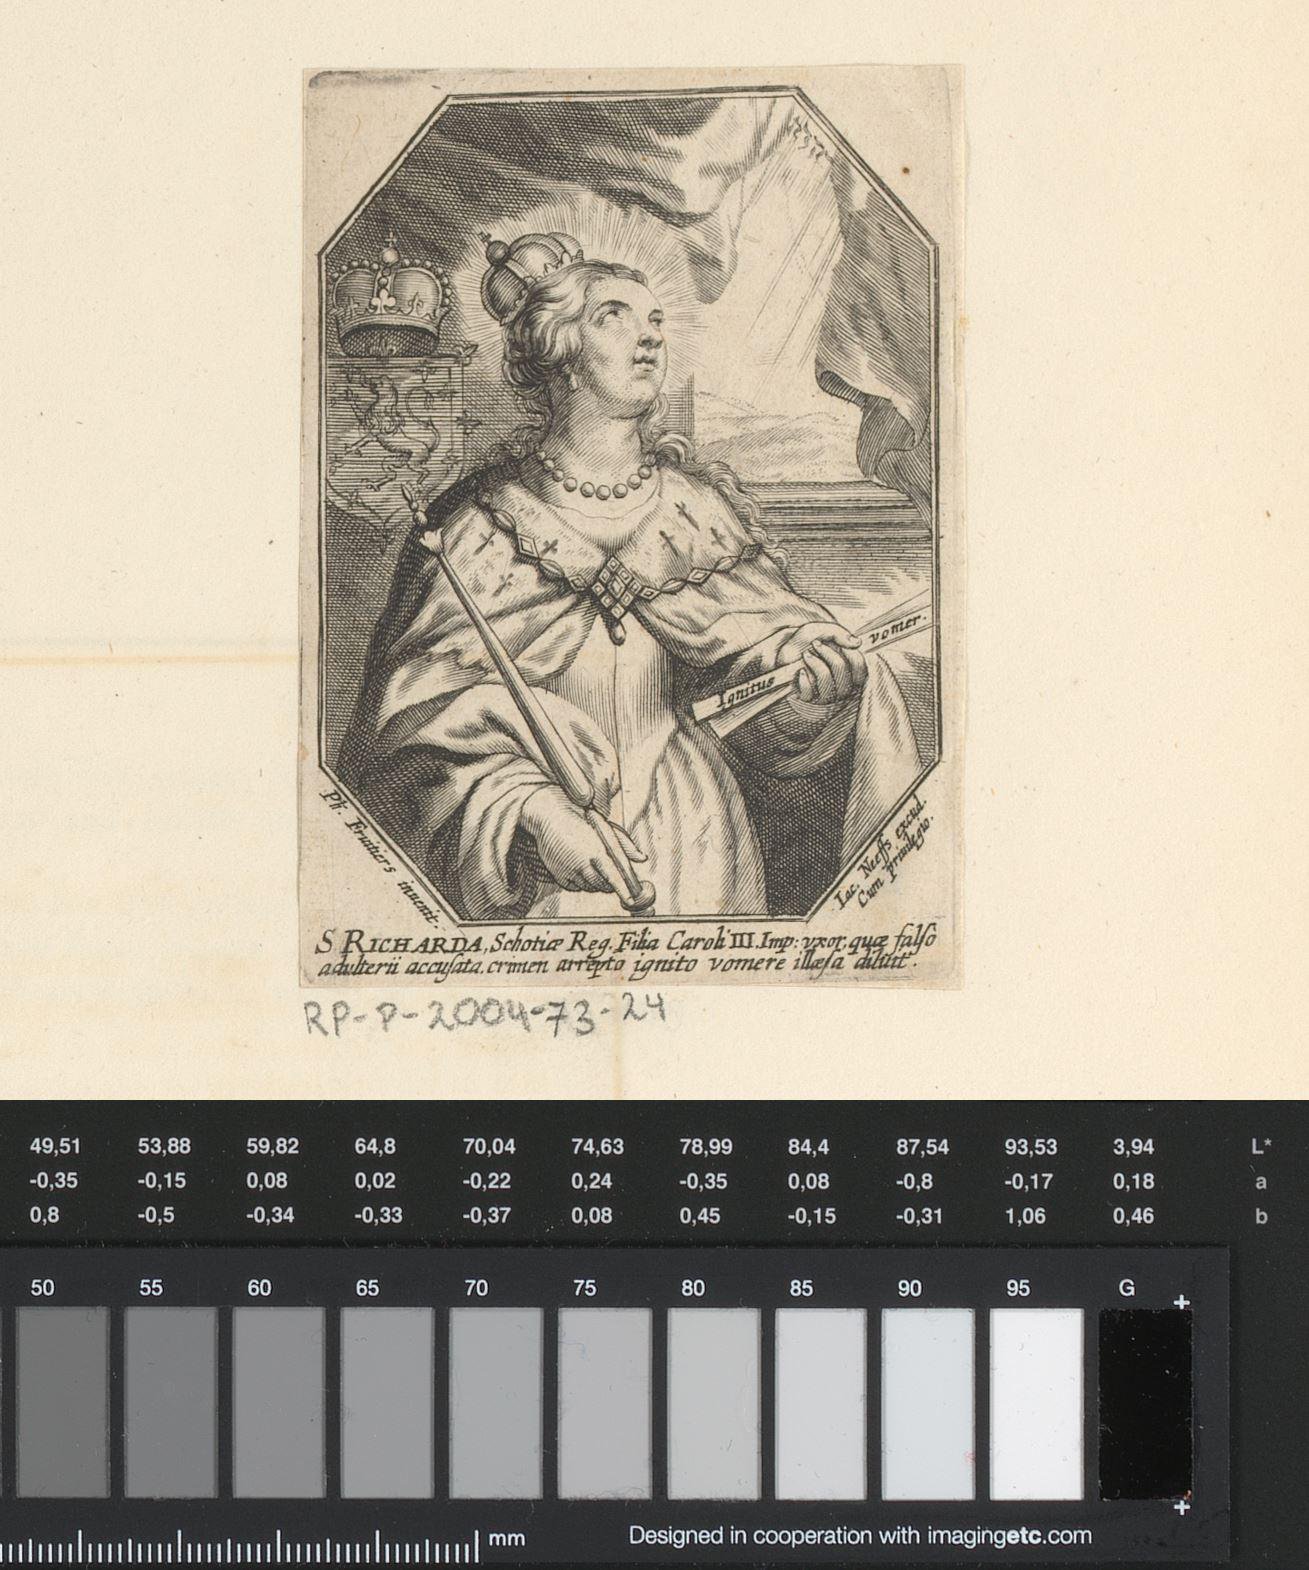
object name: print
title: Personificatie van Rijkdom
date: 1632-1661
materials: paper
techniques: engraving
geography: antwerp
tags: wealth, opulence; 'opulenza', 'richezza' (ripa)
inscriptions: : ‘Ignitus vomer’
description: De samensteller heeft deze prent in het album geplakt als illustratie bij: Pilkington, Matthew. A dictionary of painters, from the revival of the art to the present period. 4 dln. Londen: John Crowder, 1805, dl. 2, p. 202.